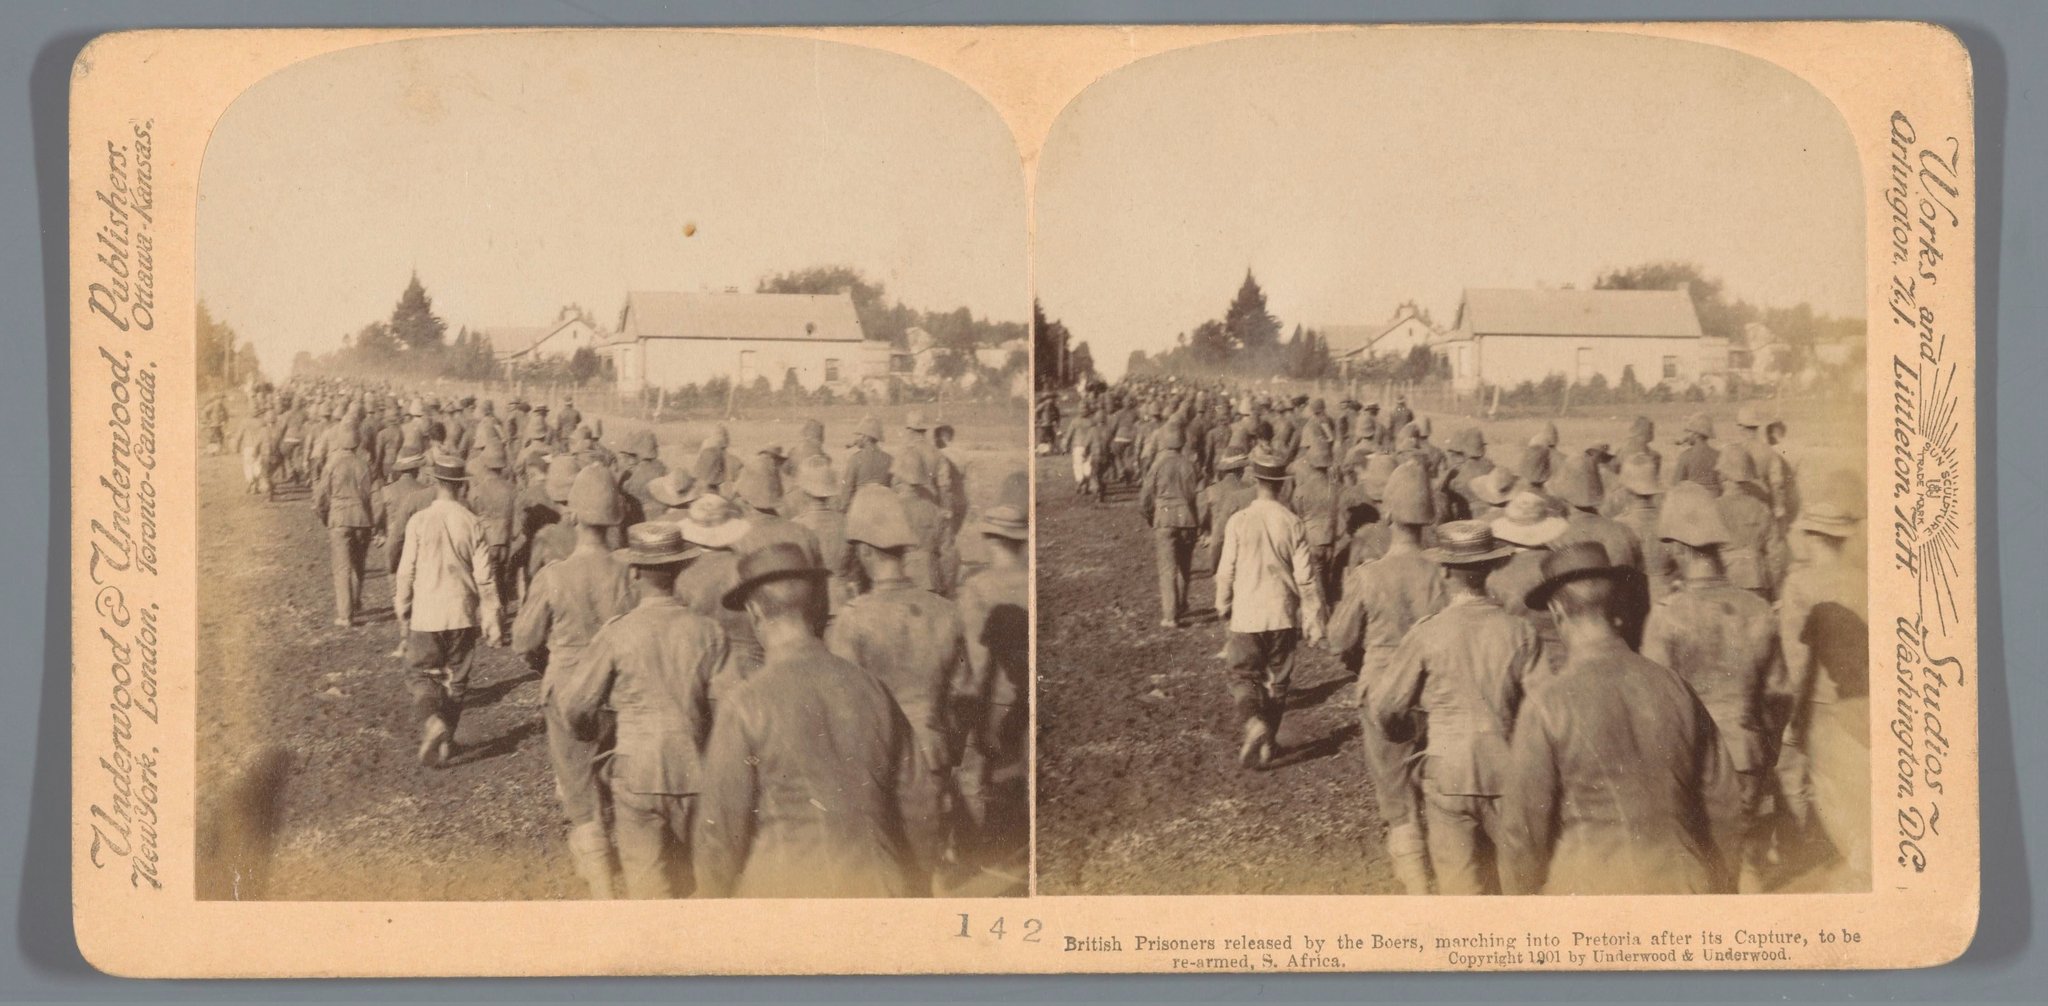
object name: stereograph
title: British prisoners released by the Boers, marching into Pretoria after its capture, to be rearmed, South Africa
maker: Anonymous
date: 1901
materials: cardboard, paper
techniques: albumen print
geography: new york city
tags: release from prison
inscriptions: inscription: ‘Works and Studios ~/ Arlington, N.J. Littleton, N.H. Washington, D.C.’, inscription, copyright notice: ‘Copyright 1901 by Underwood & Underwood.’, number: ‘142’